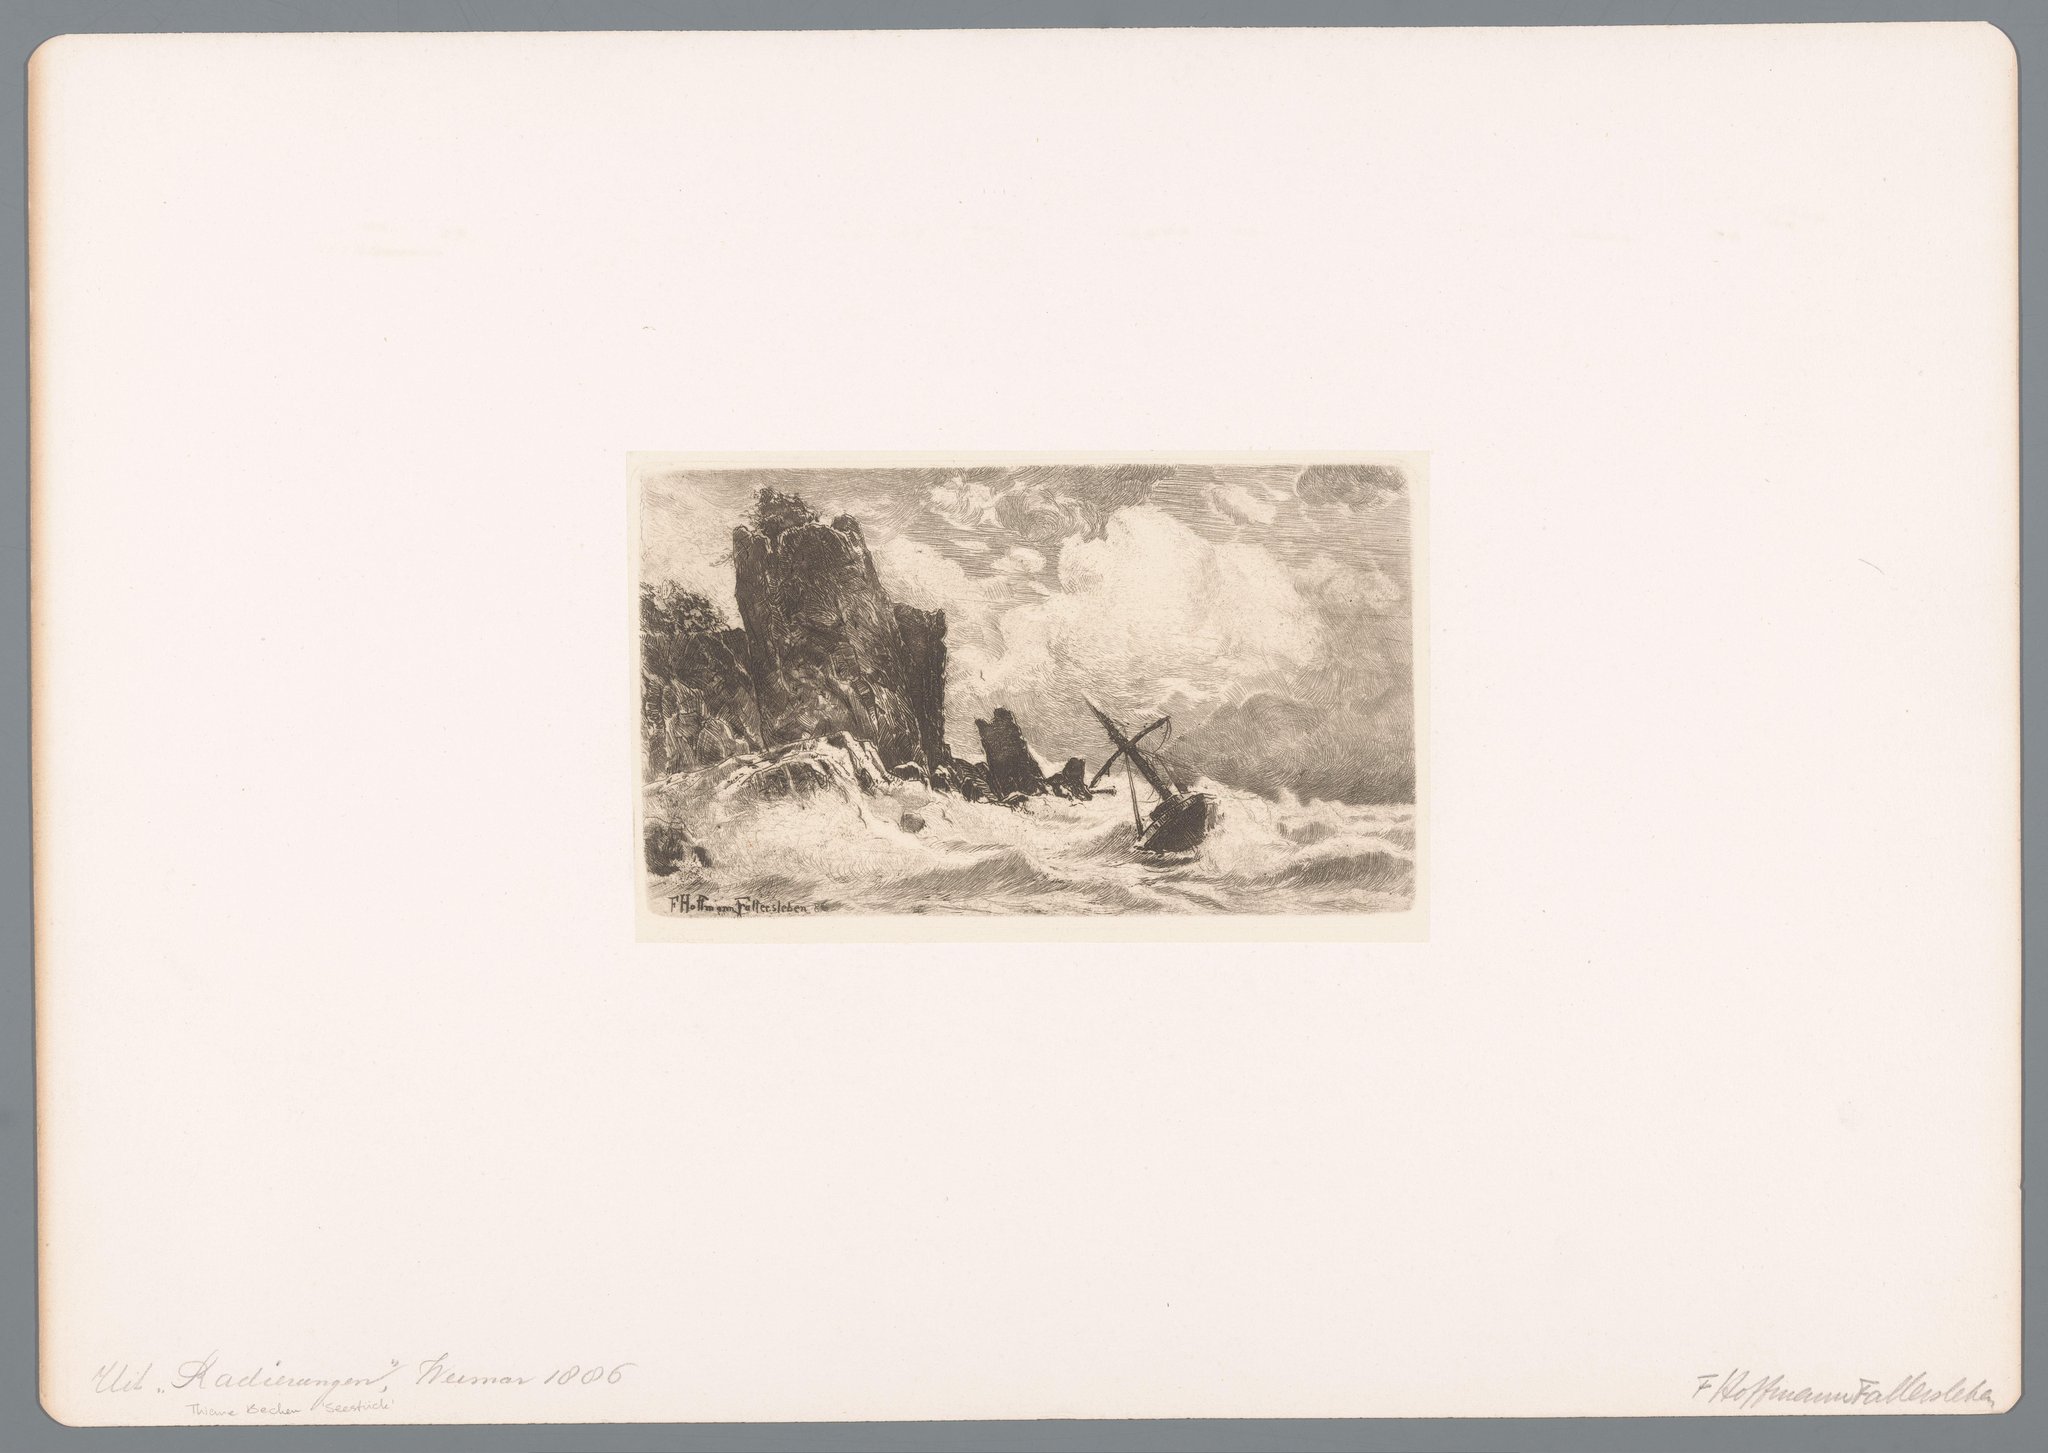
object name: print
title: Stormachtige kust met zeilboot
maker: franz hoffmann-fallersleben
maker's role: painter, print maker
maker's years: 1855-1924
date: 1886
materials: paper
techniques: etching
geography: weimar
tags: sailing-ship, sailing-boat, storm, rock-formations, sea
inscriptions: collector's mark: Lugt 2228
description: Prent uit: Radirungen. Weimar: Gesellschaft für Radierkunst zu Weimar, 1886.